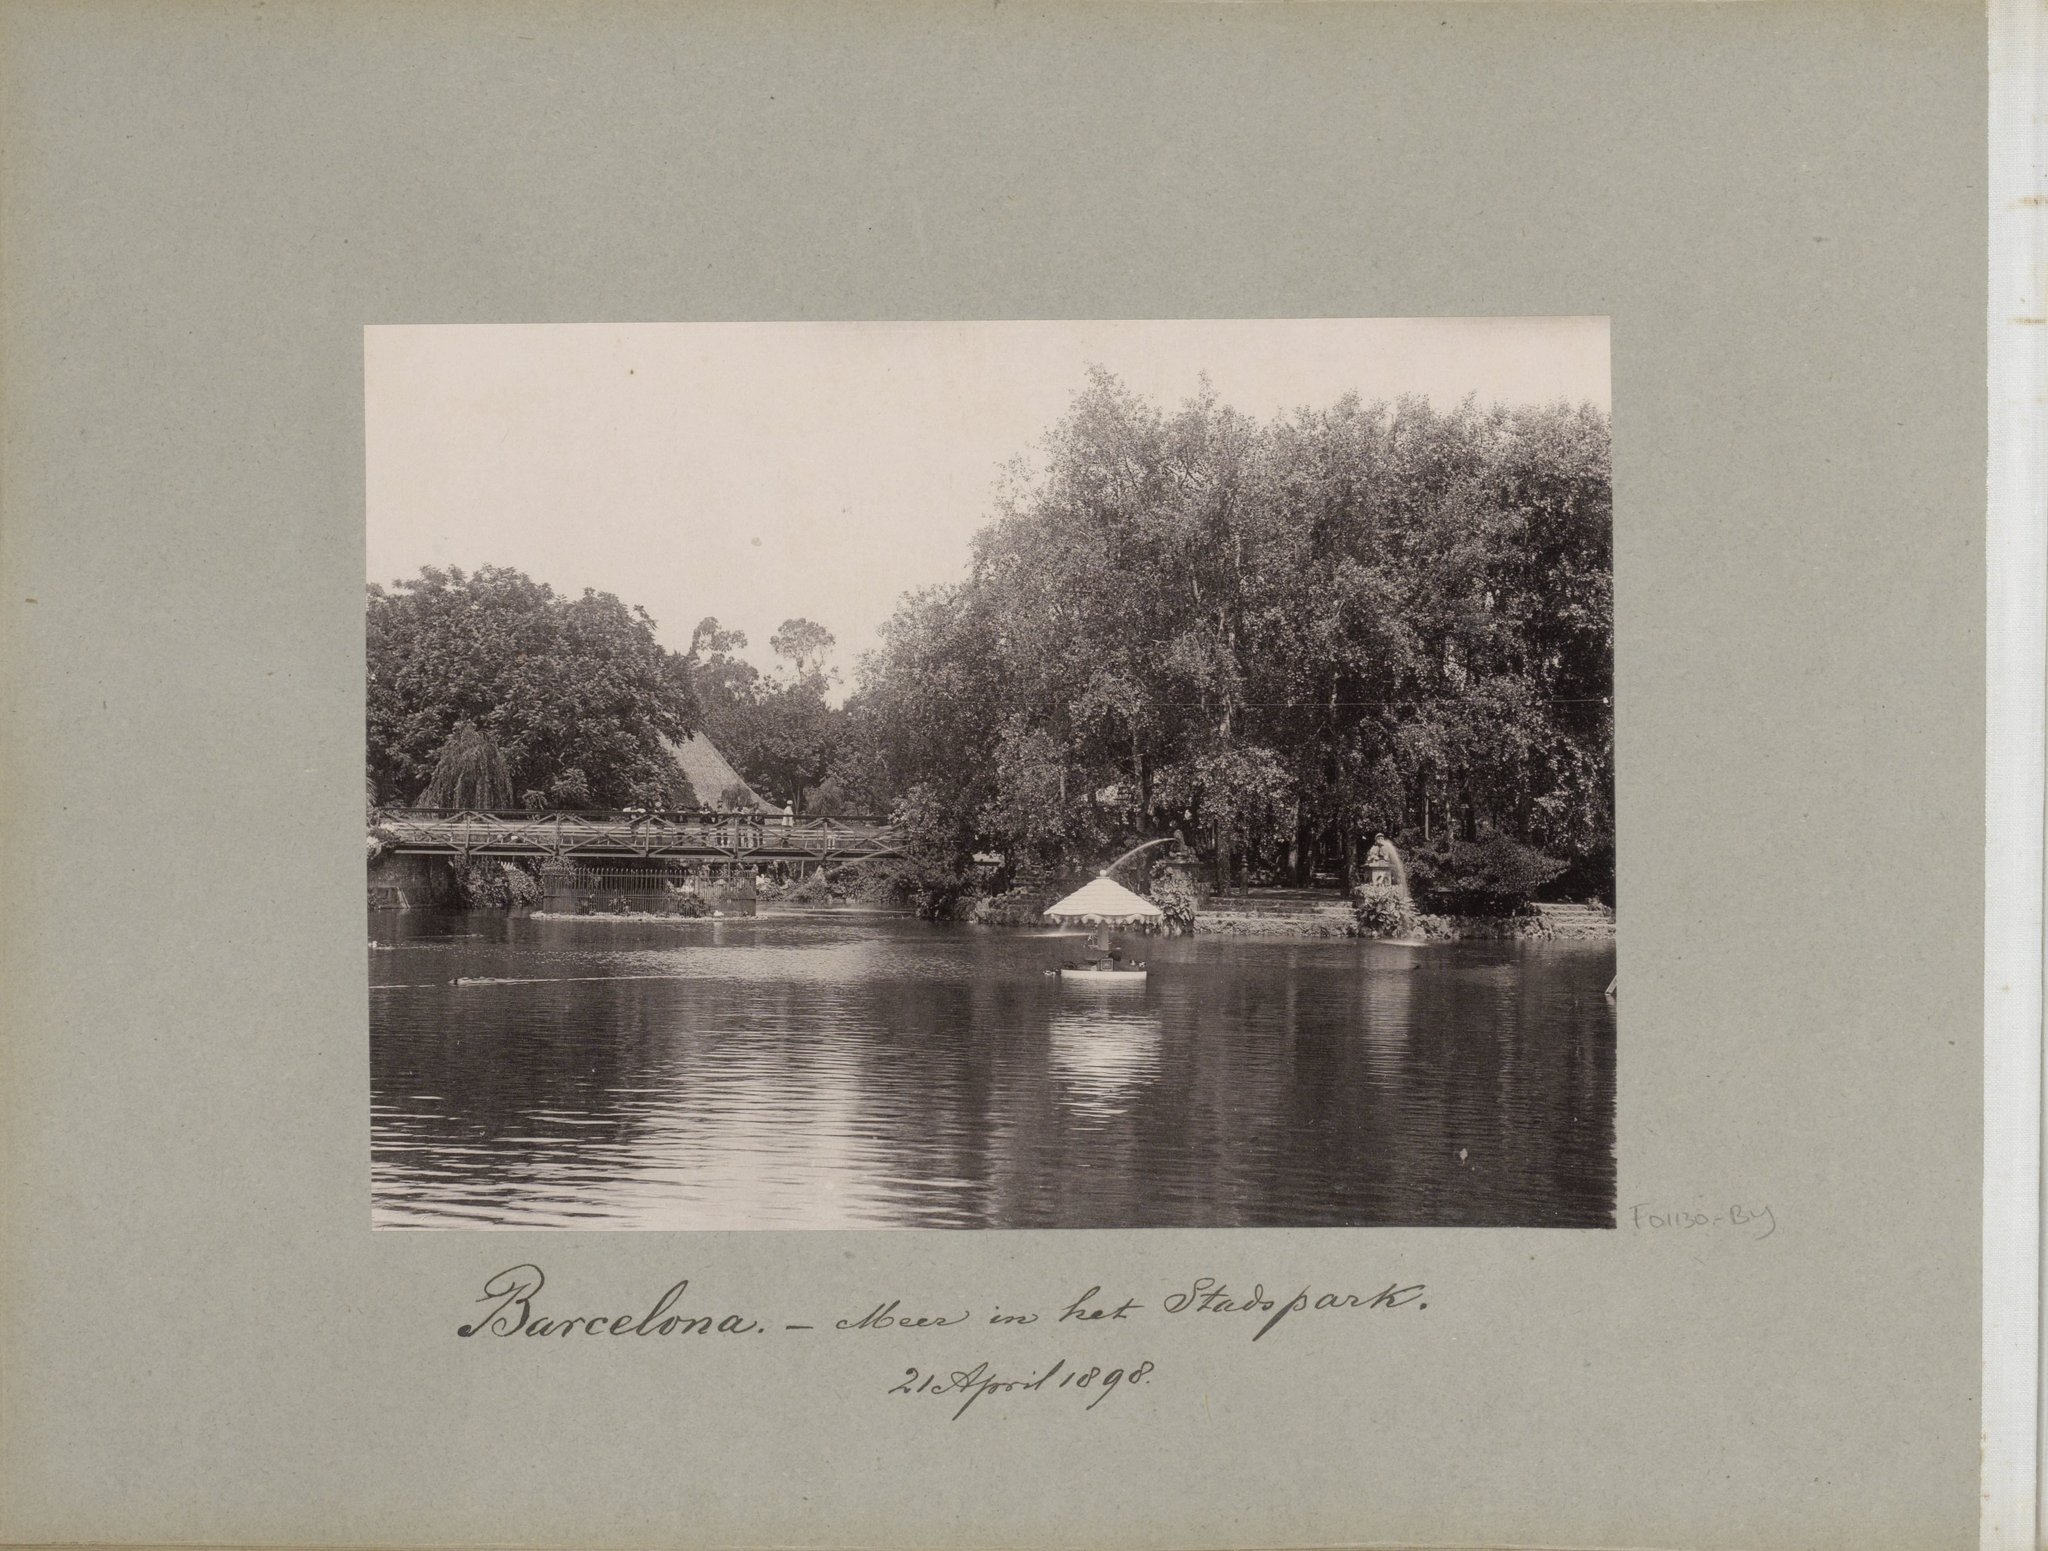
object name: album leaf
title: Vijver in het stadspark van Barcelona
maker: Anonymous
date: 1880-1898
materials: paper, ink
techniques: photograph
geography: barcelona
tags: pond, pool, public gardens, park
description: Onderdeel van Reisalbum met foto's van bezienswaardigheden in Frankrijk, Spanje, Italië, Duitsland, Zwitserland en Oostenrijk.